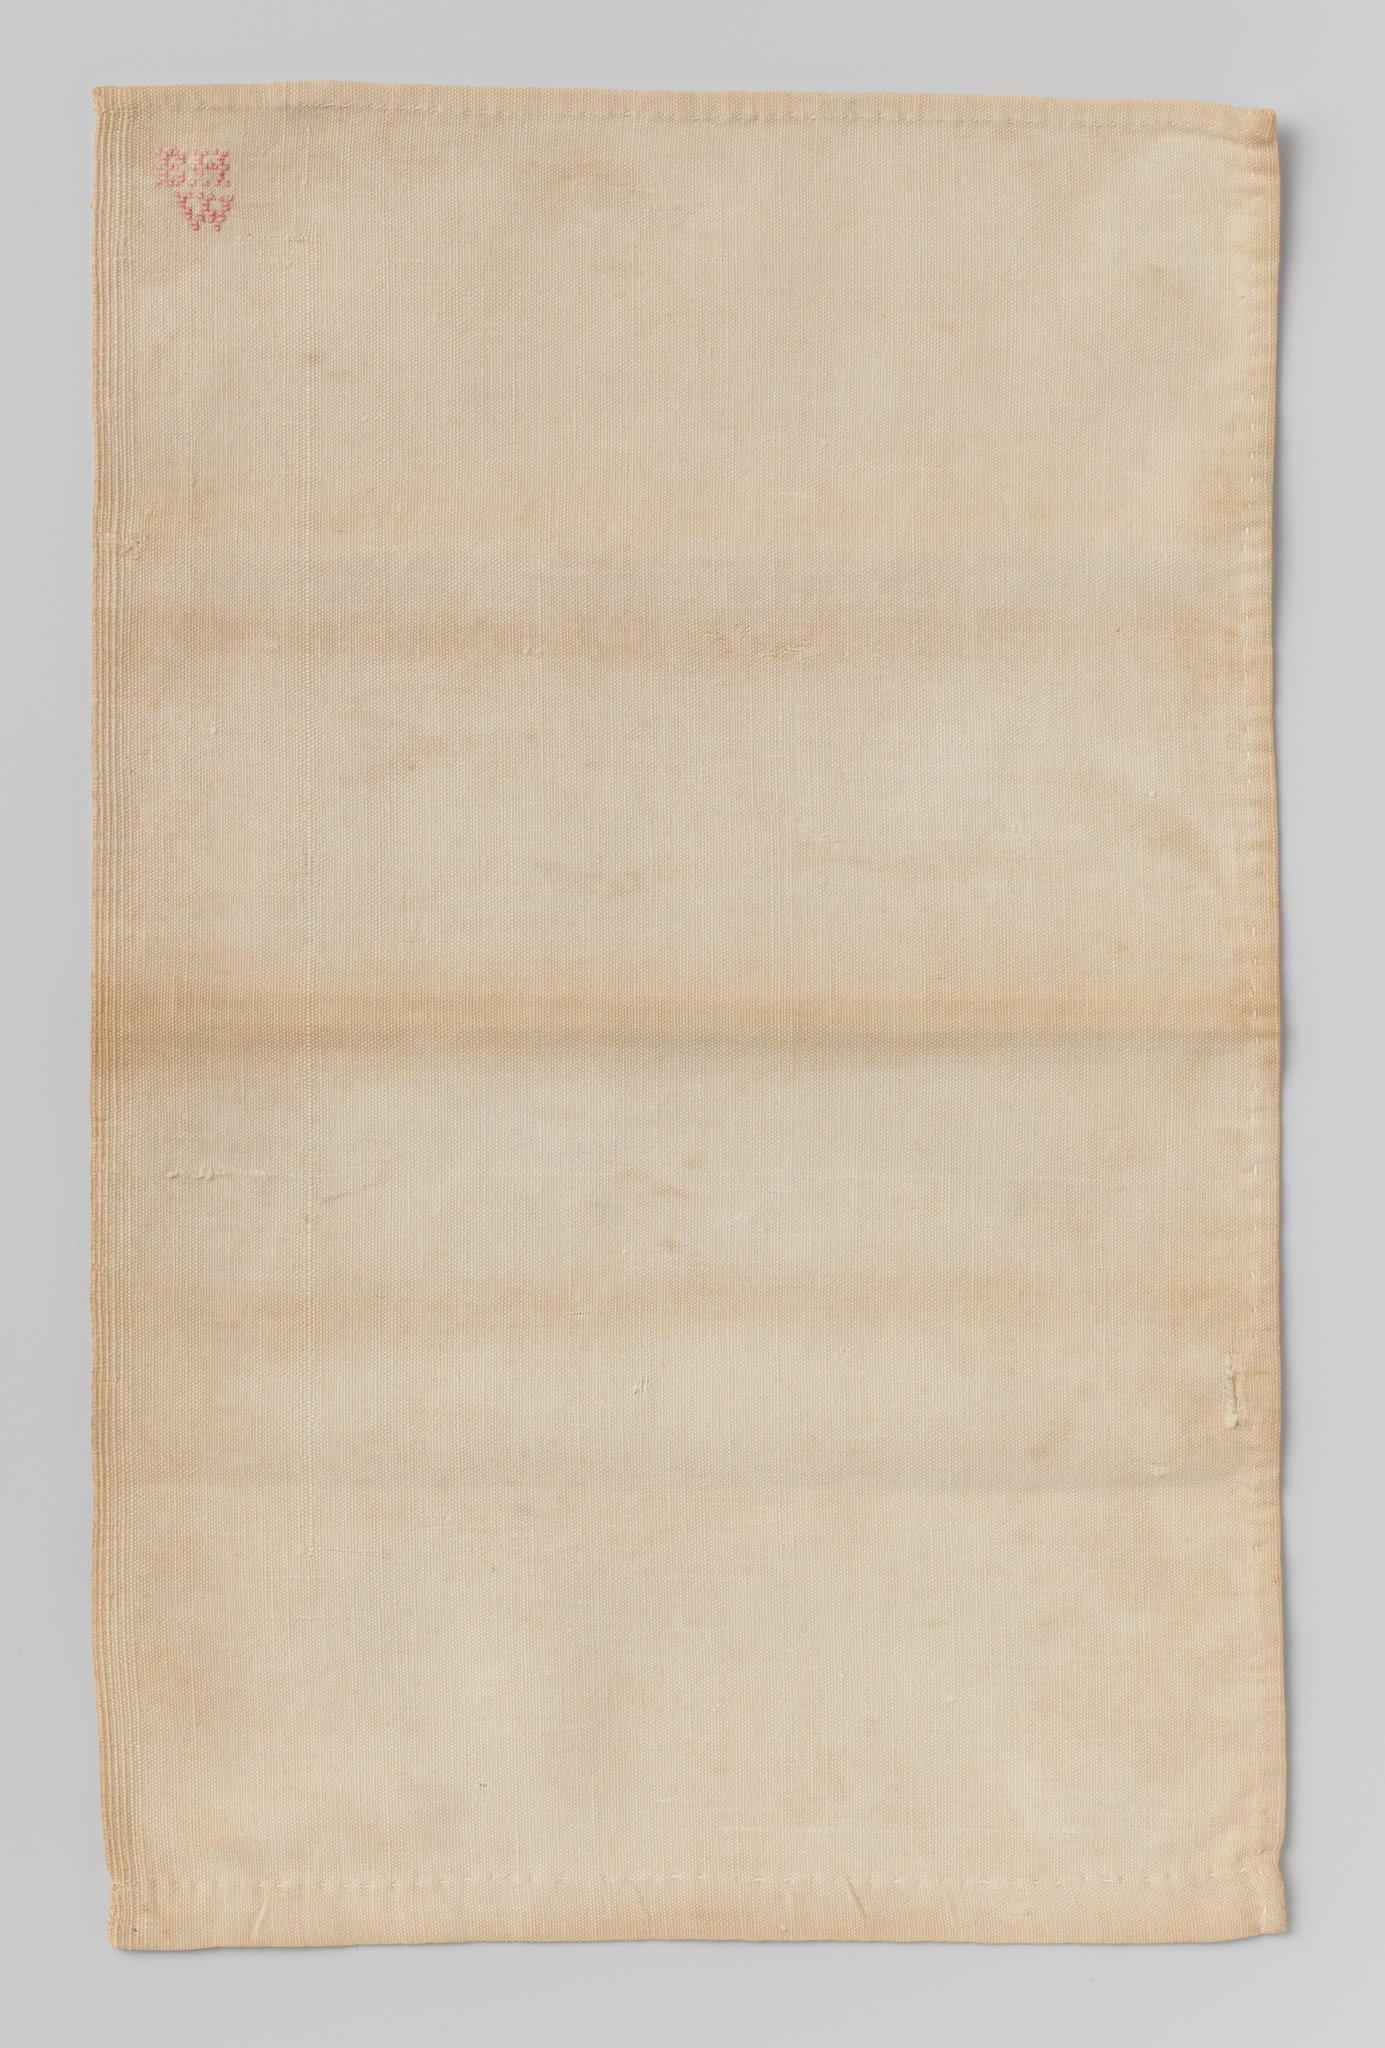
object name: beddenlaken, laken object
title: Laken, gemerkt BHW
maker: Anonymous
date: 1750-1850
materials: linen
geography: netherlands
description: Een grof linnen laken, aan twee zijden omzoomd met smalle zoom; bovenzijde met brede zoom, één zelfkant. Met monogram BHW in kruissteek met draad van roze katoen.